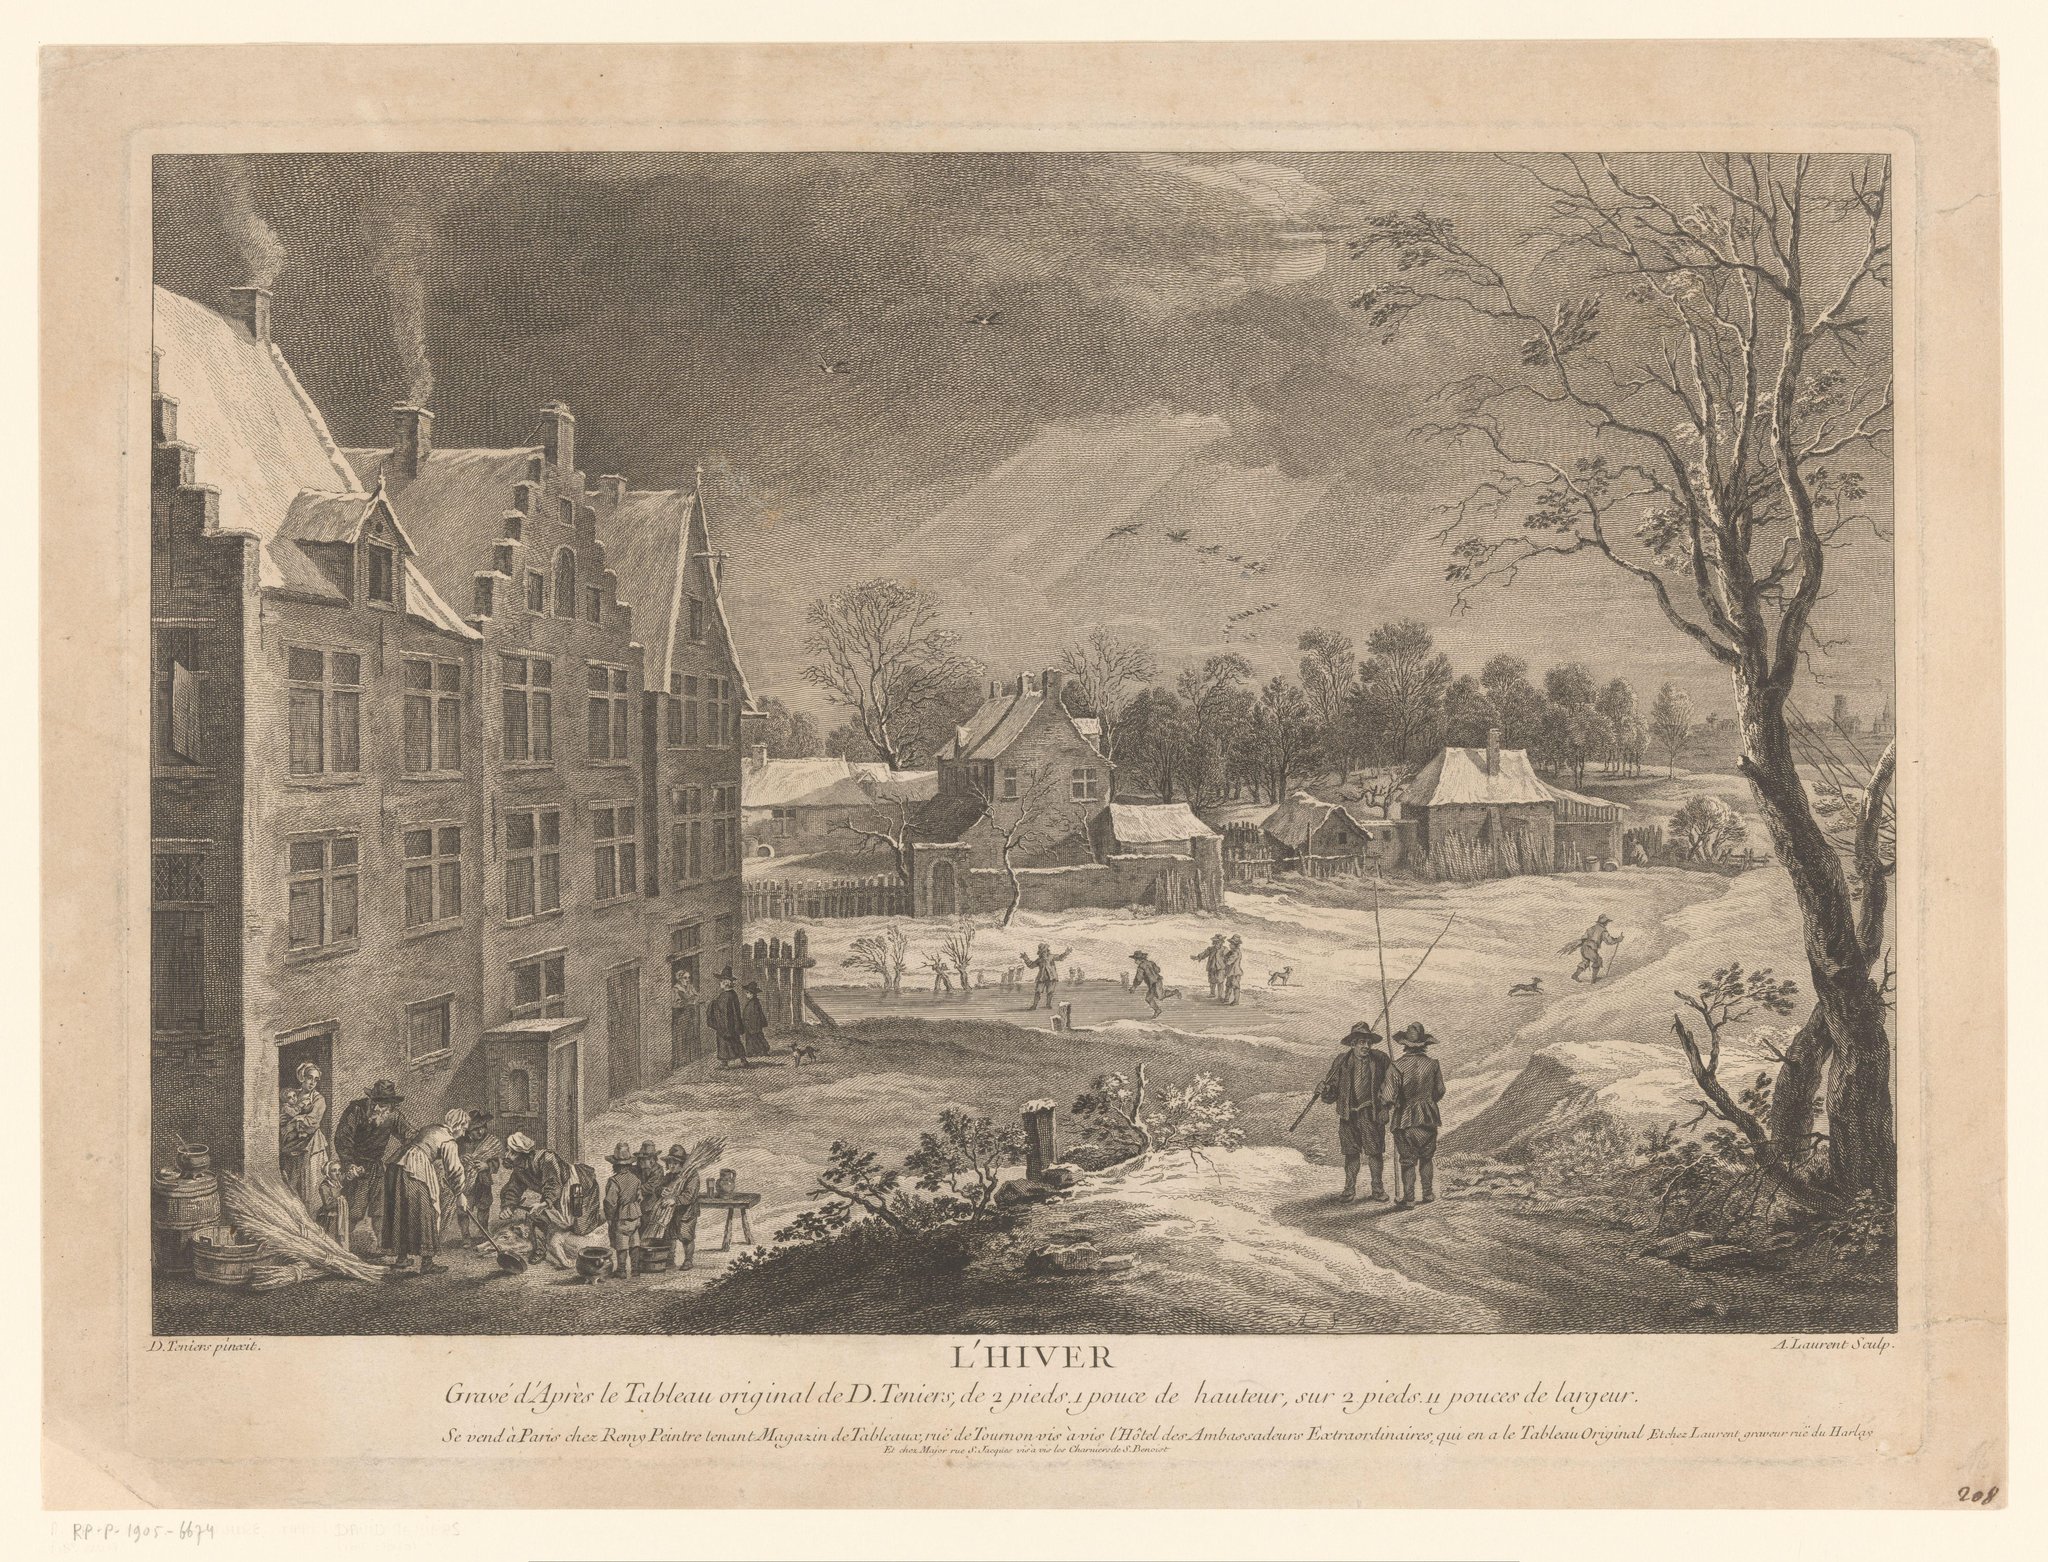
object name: print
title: L'hiver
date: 1718-1747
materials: paper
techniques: engraving, etching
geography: paris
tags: winter ~ human activities (the four seasons of the year), village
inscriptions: collector's mark: Lugt 2228, number: ‘208’